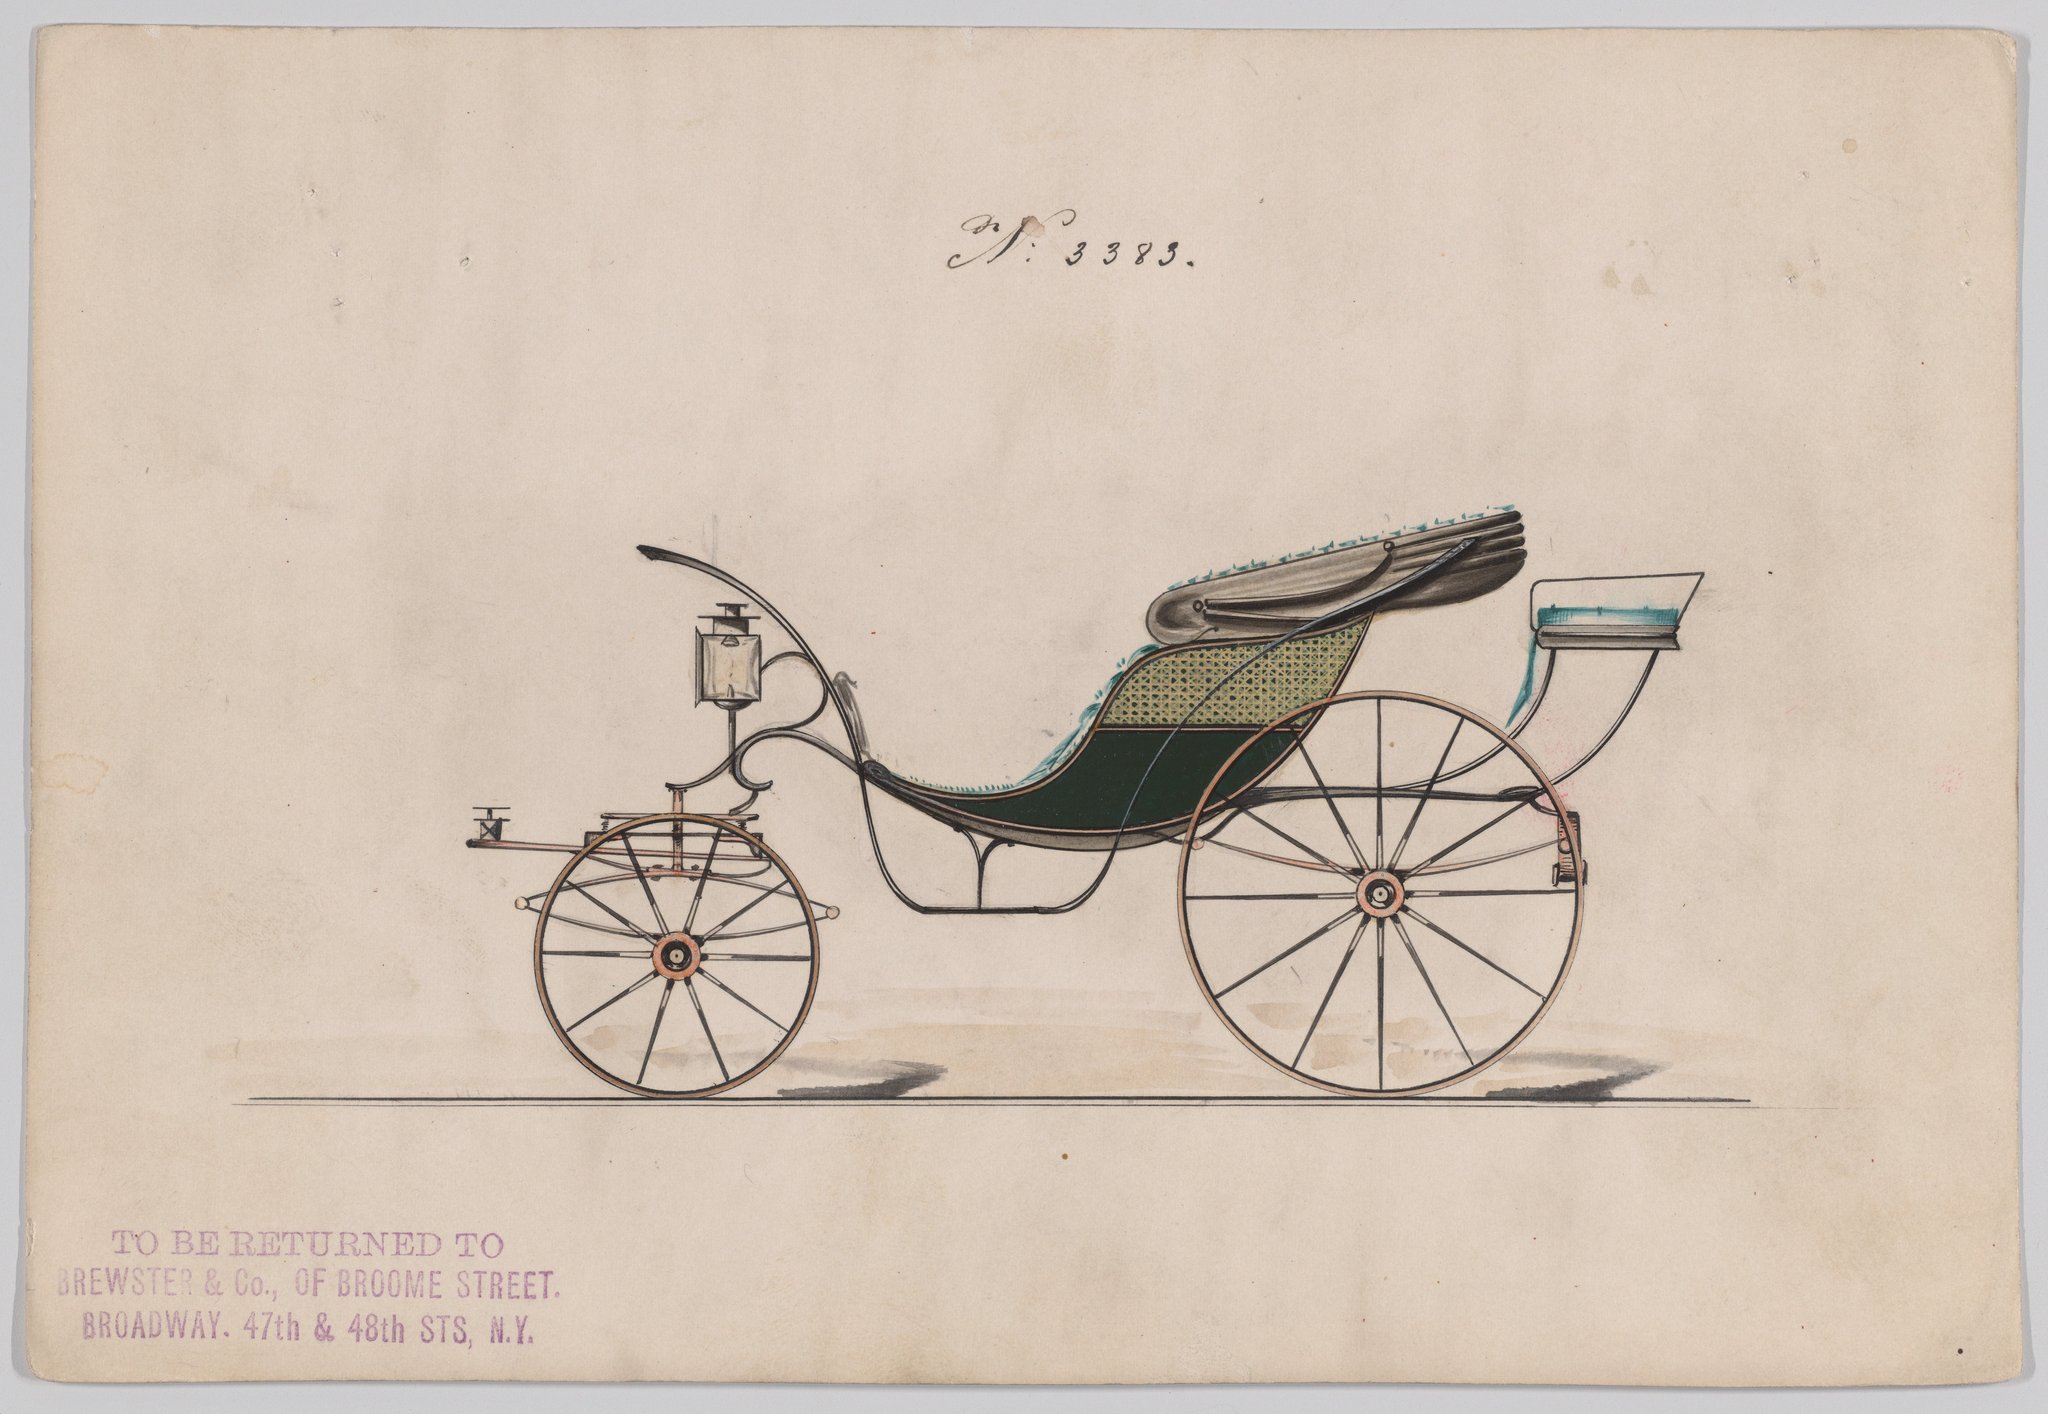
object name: drawing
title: Design for Pony Phaeton, no. 3383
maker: brewster & co.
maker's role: manufacturer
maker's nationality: american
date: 1877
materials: gouache, graphite, gum arabic, ink, watercolor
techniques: pen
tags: carriages